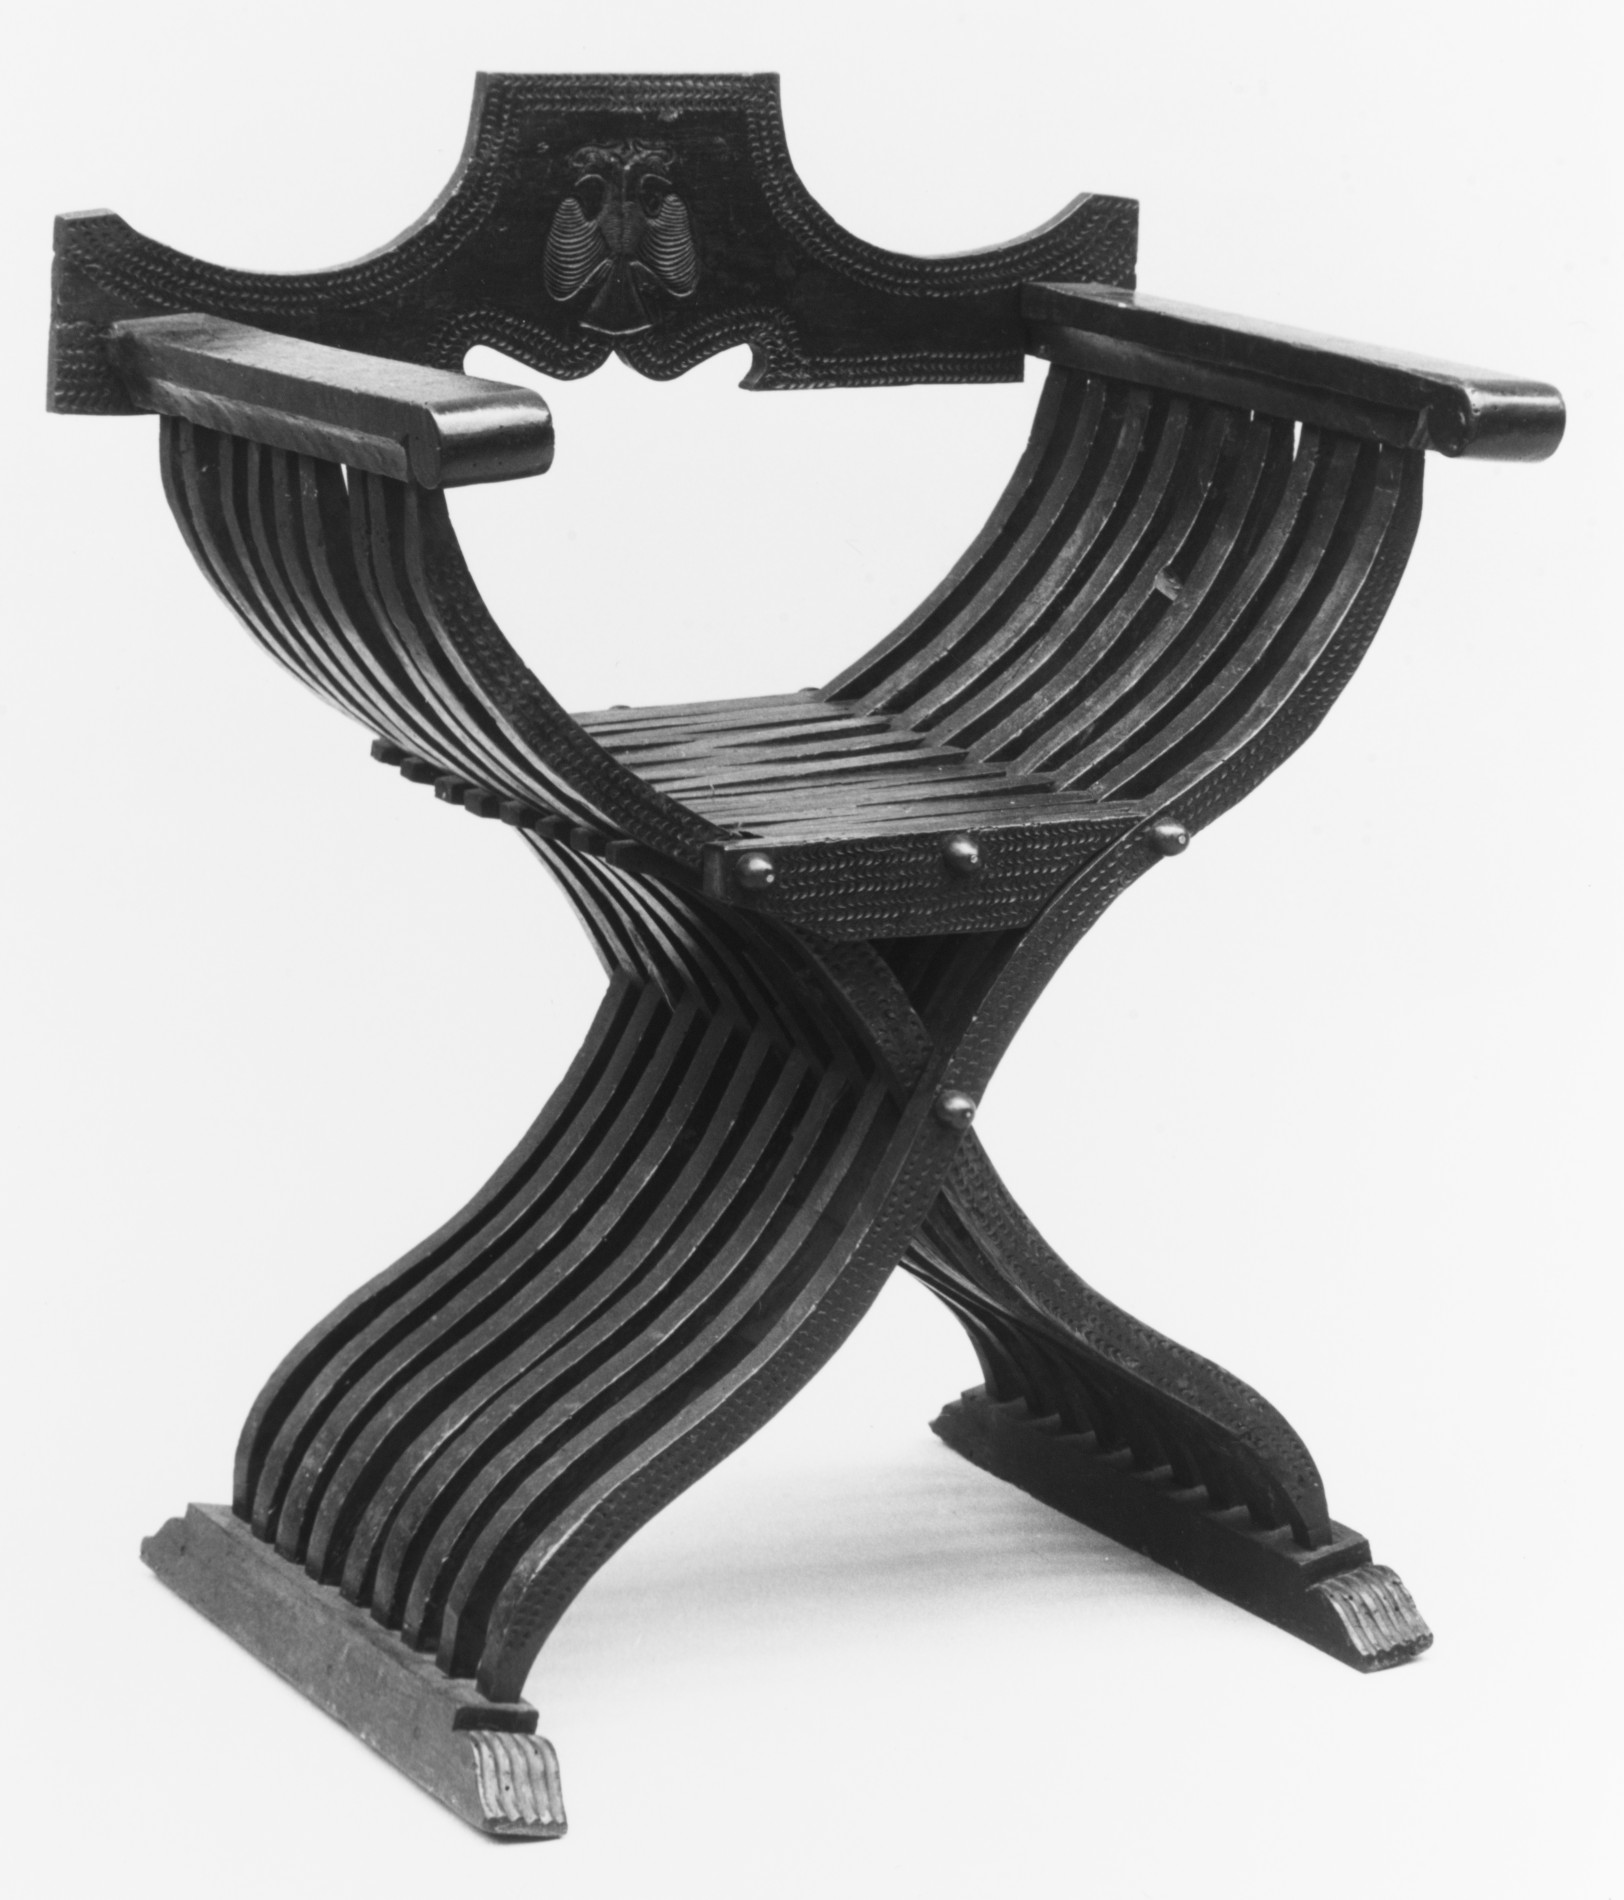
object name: armchair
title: Folding armchair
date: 1501-1600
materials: wood